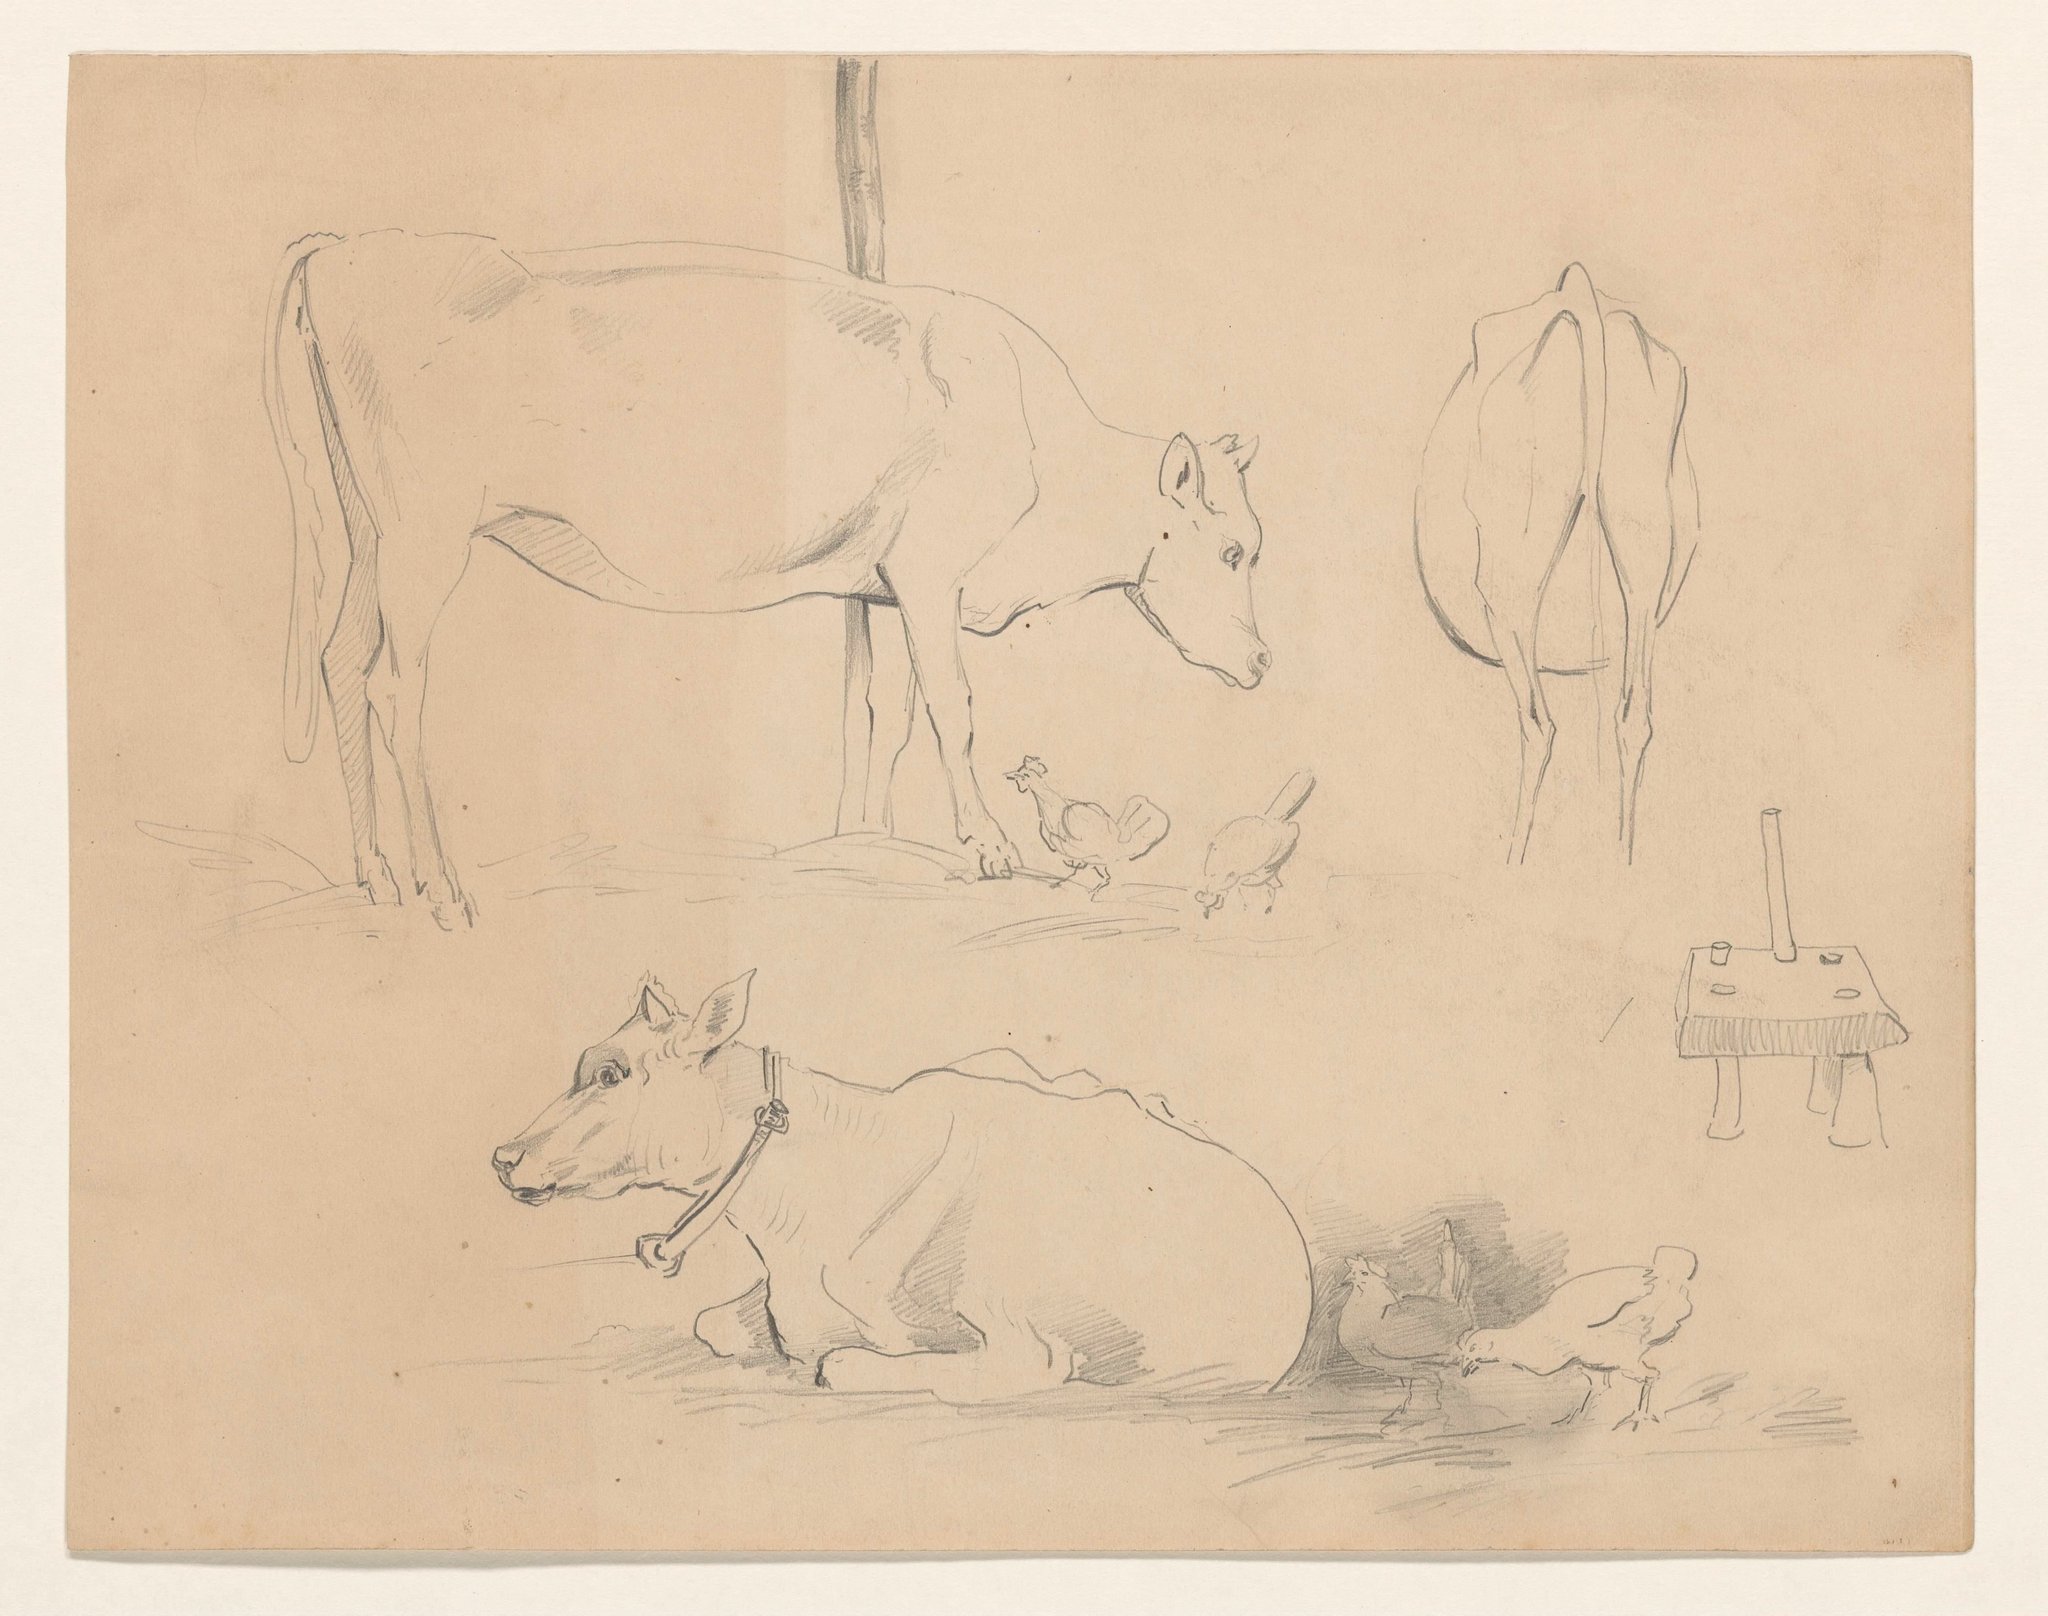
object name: drawing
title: Studies van een kalf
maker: johannes tavenraat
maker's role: draughtsman, painter, print maker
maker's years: 1809-1881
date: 1819-1881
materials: paper, pencil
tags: calf